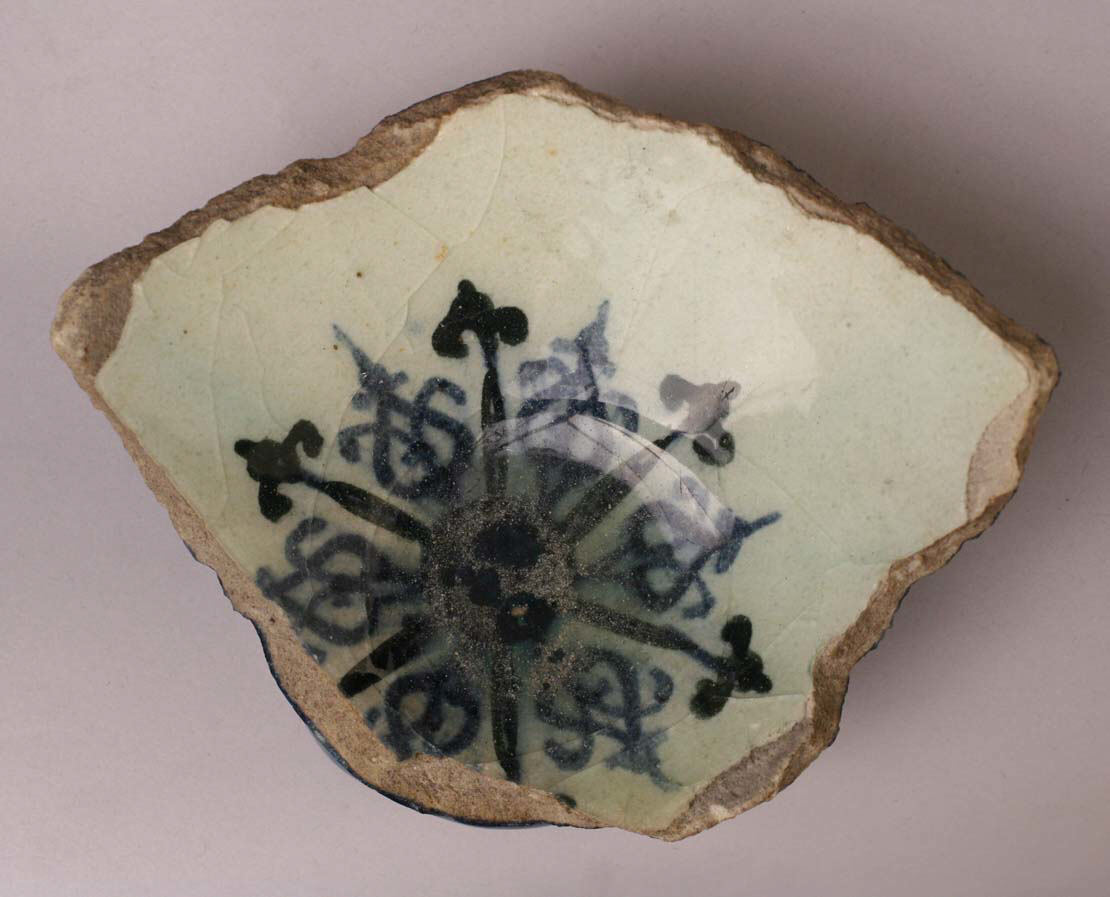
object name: fragment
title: Ceramic Fragment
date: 1201-1600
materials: glaze, stonepaste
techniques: painting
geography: egypt